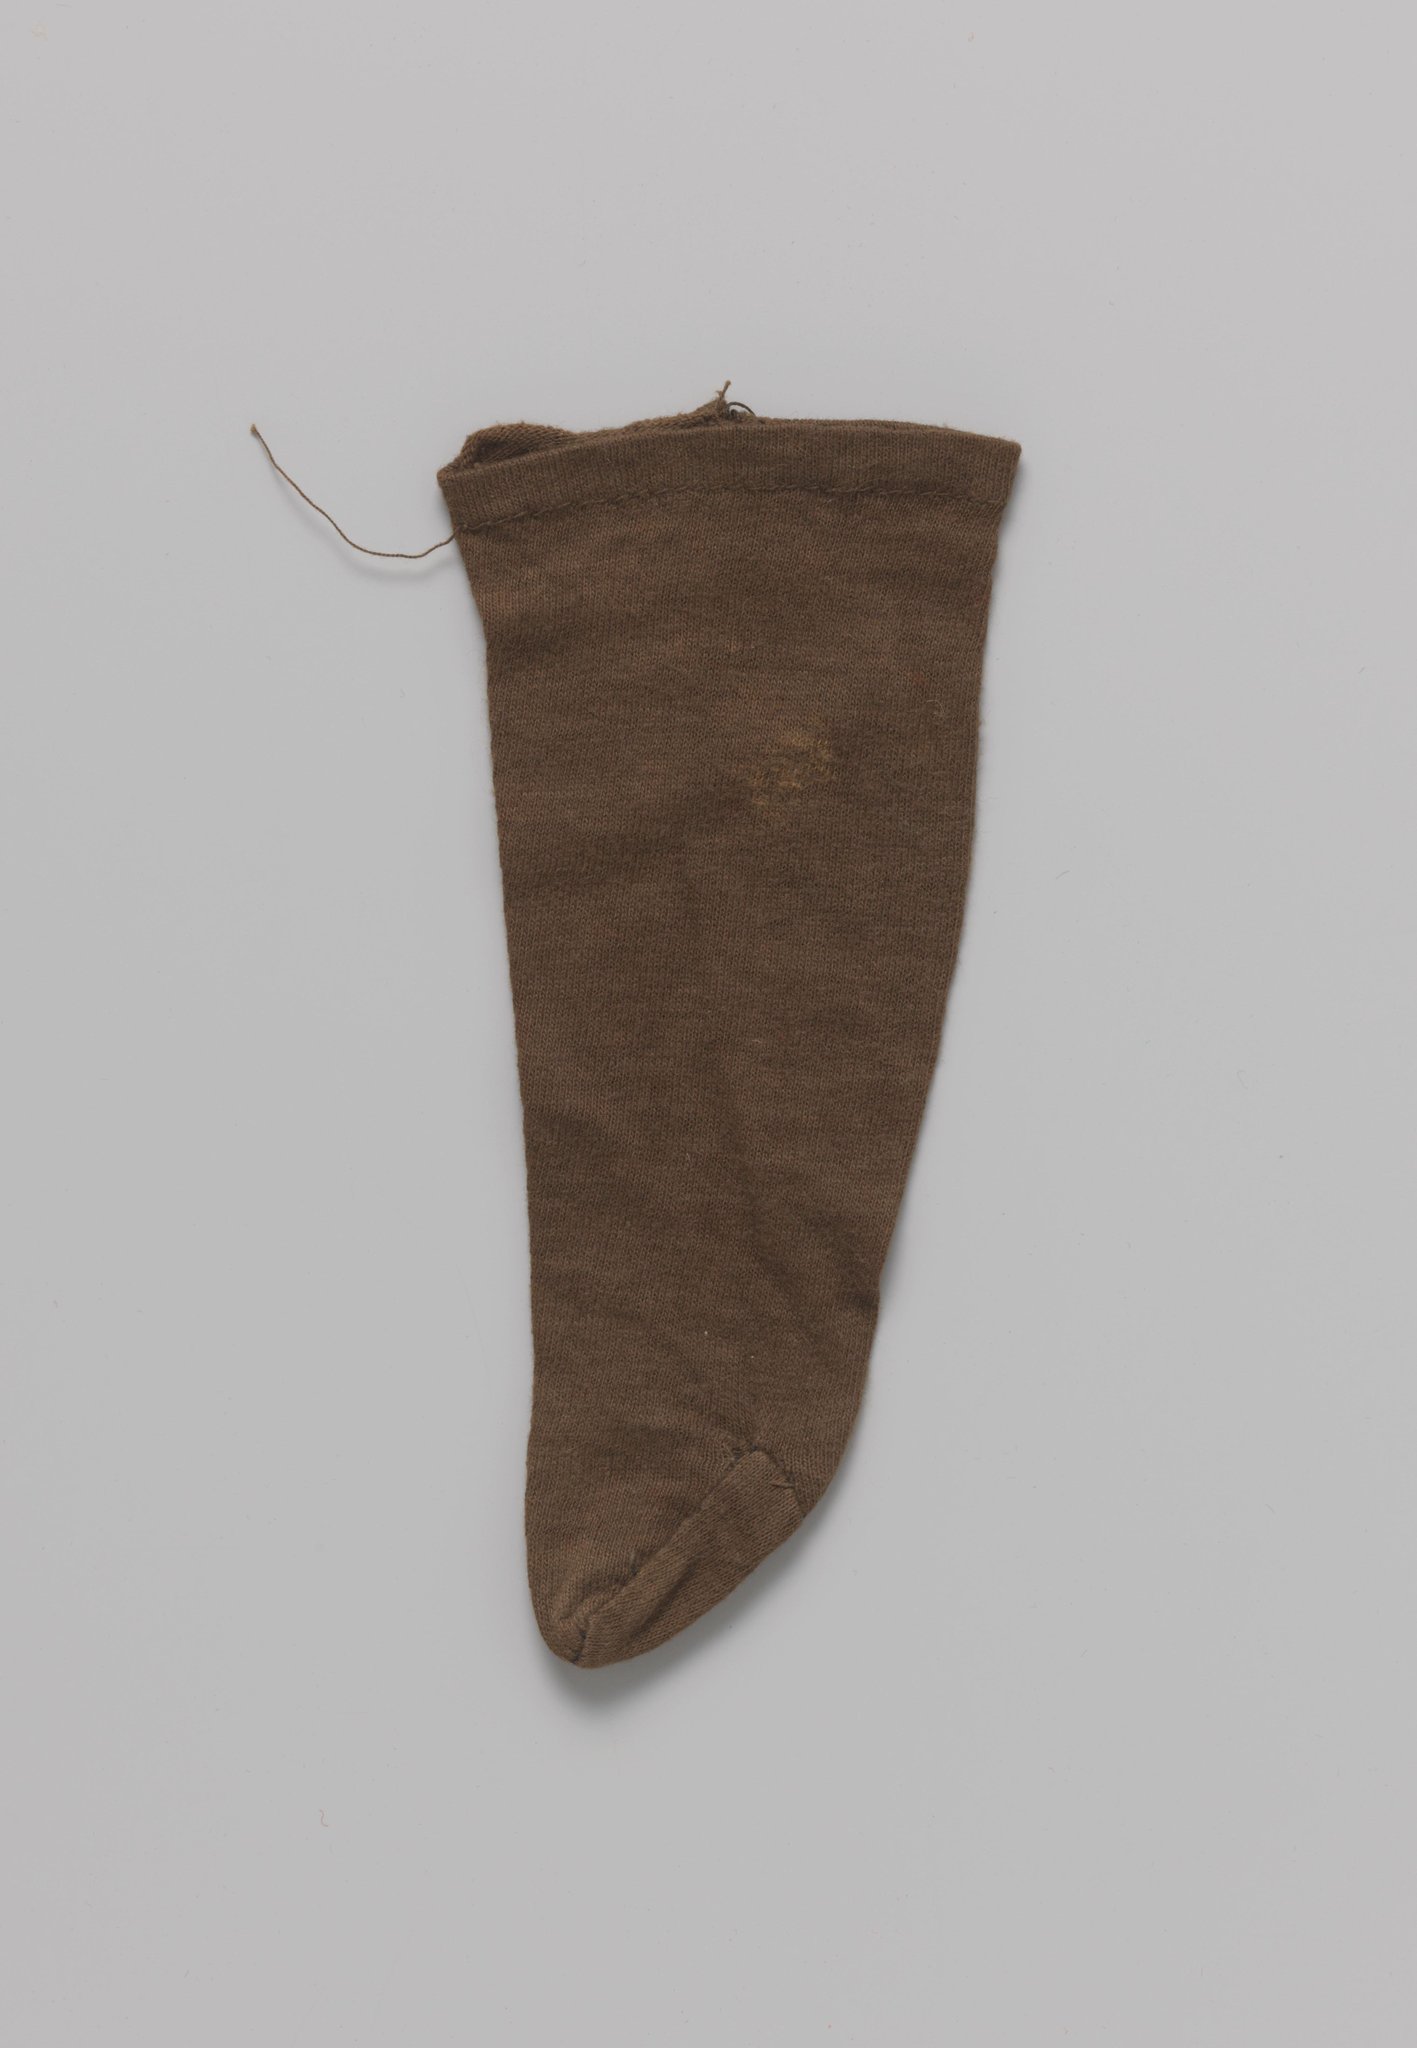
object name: doll's clothing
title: Sok van bruine tricot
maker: Anonymous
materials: textile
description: Sok van bruine tricot. Slechts één exemplaar.